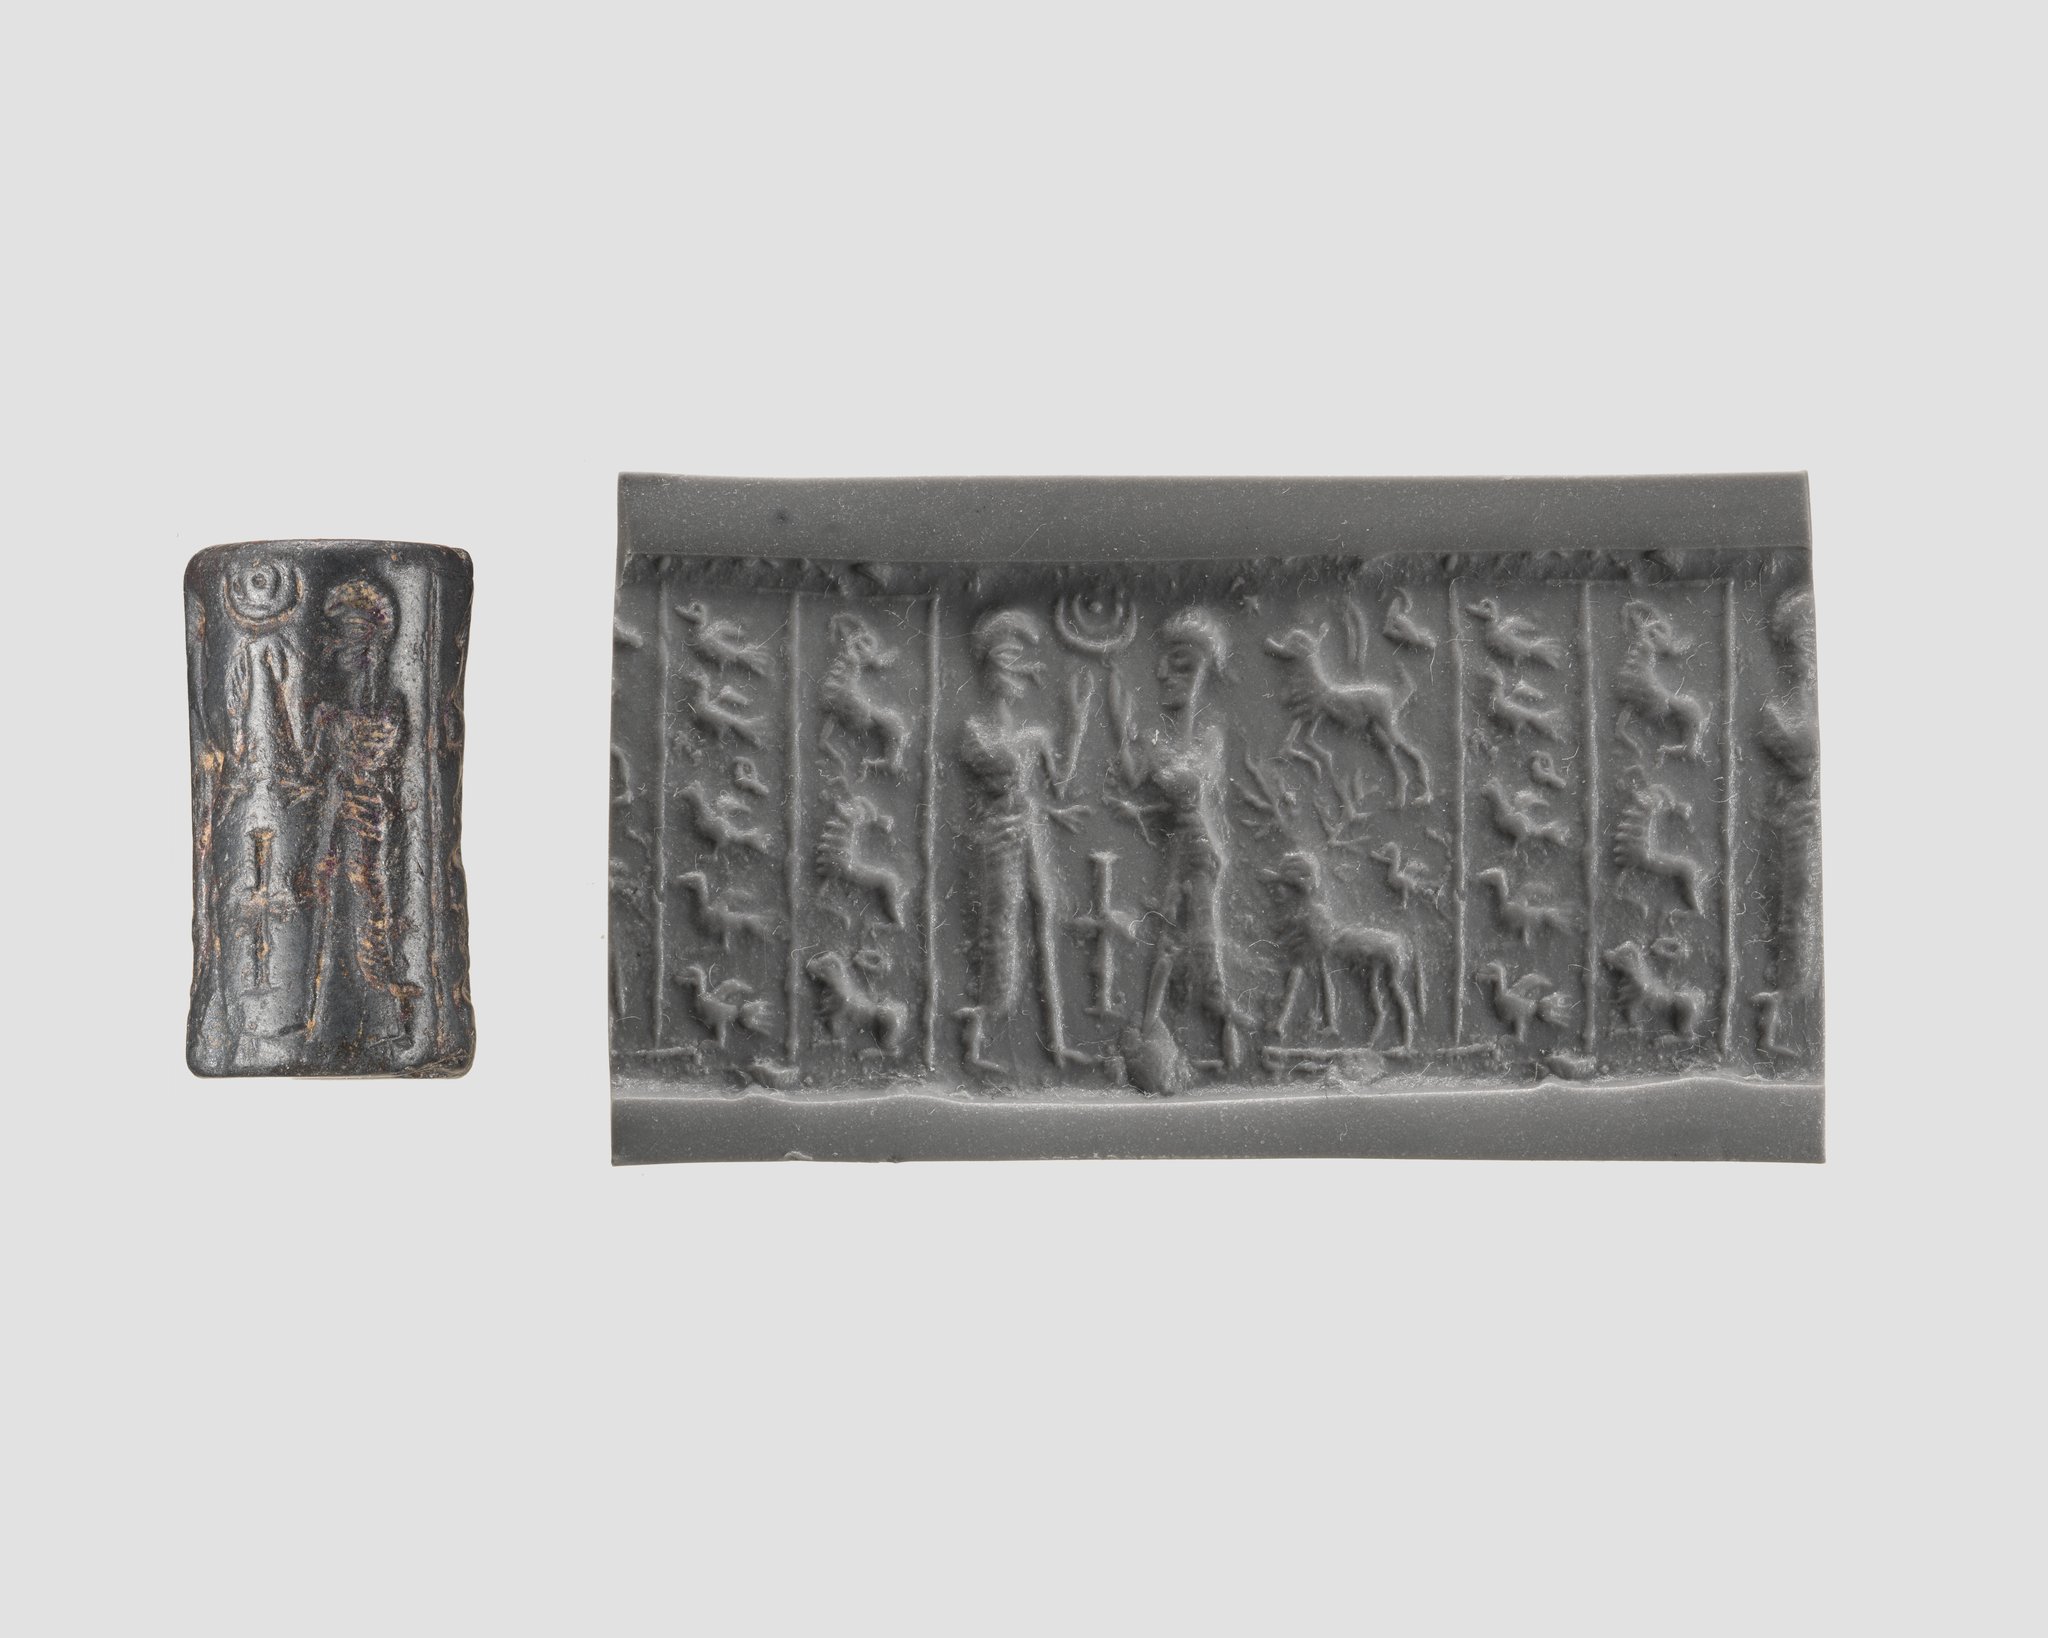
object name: cylinder seal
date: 1720-1650 BCE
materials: mineral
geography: syria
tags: animals